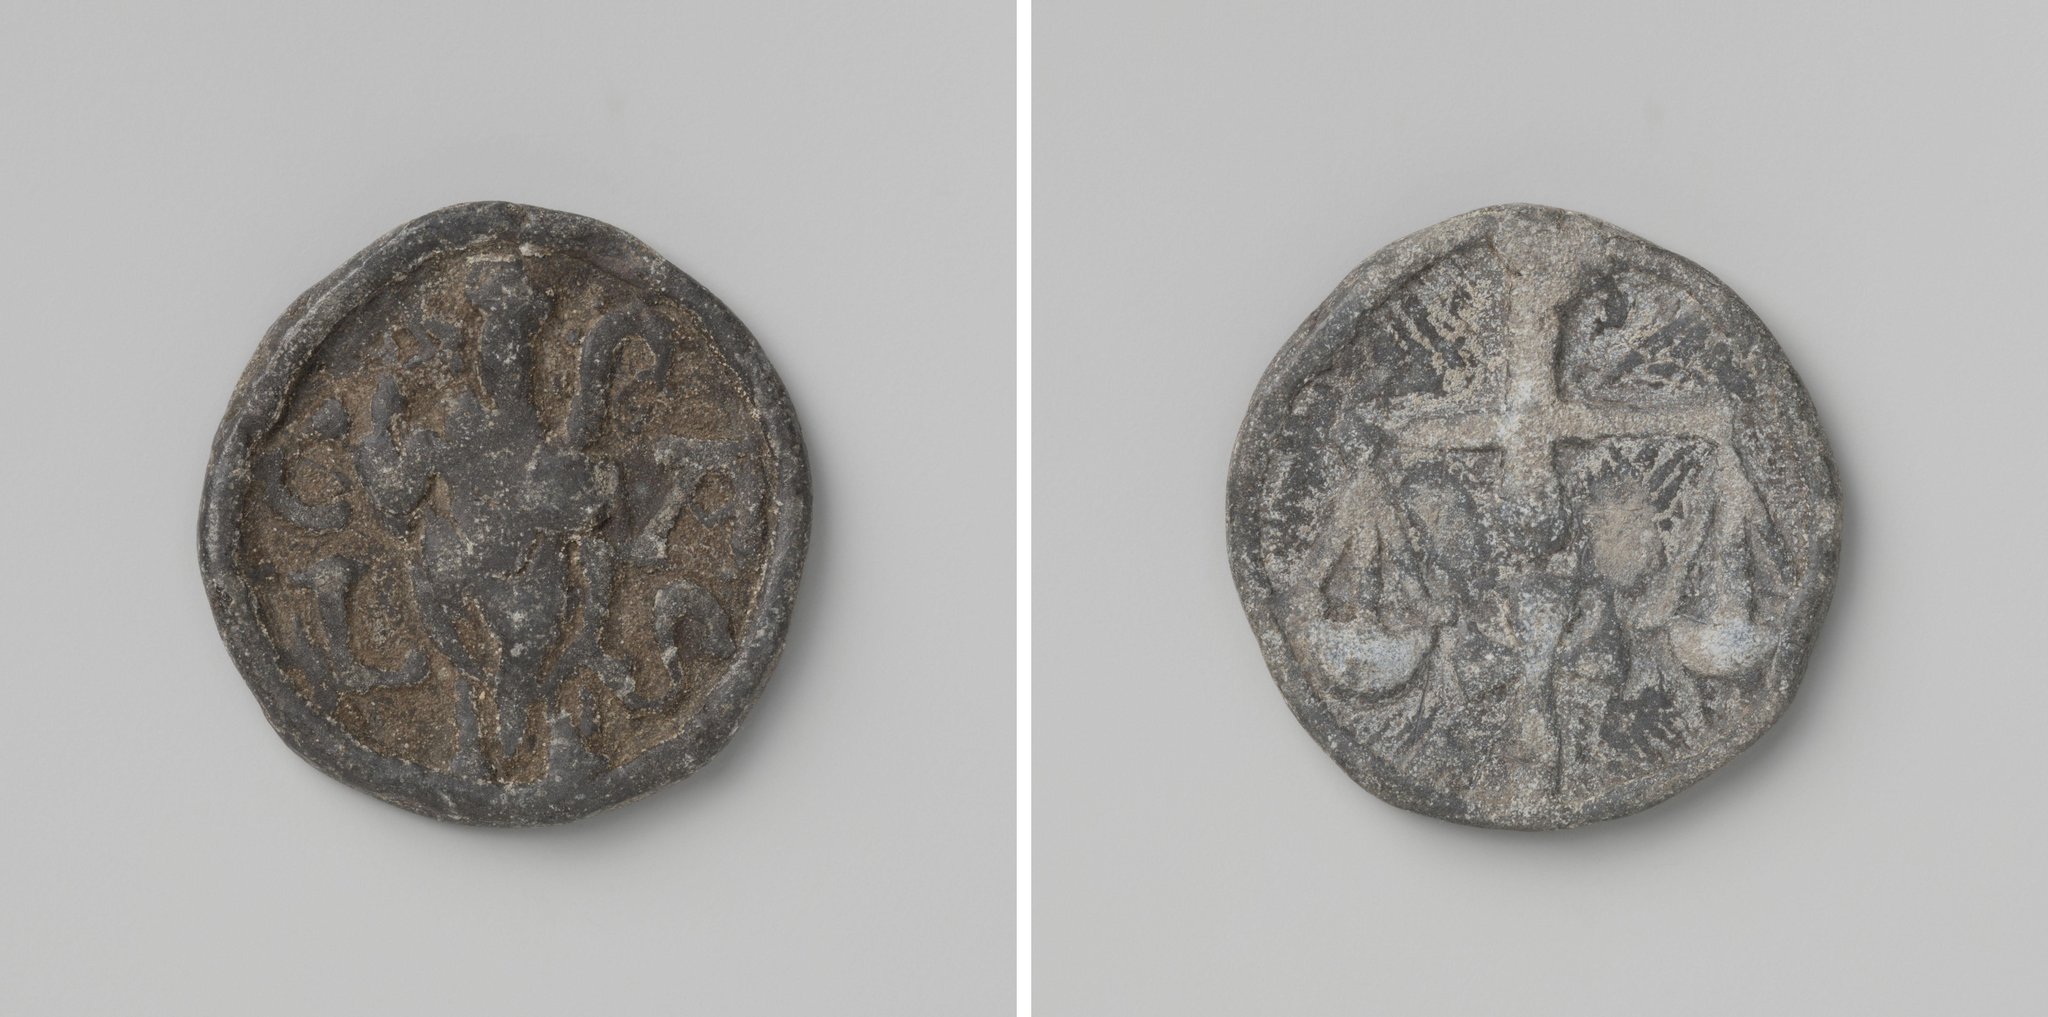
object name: armenloodje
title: Kramers- St. Nicolaasgilde van Arnhem, loodje dat bij uitdeling onder de armen recht op brood gaf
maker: Anonymous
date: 1600-1800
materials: lead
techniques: casting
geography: arnhem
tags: arnhem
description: Loden penning. Voorzijde: gemijterde St. Nicolaas met staf in linkerhand zegent met geheven rechterhand binnen omschrift. Keerzijde: omgeven door stralend licht: in evenwicht hangende weegschaal boven kruis